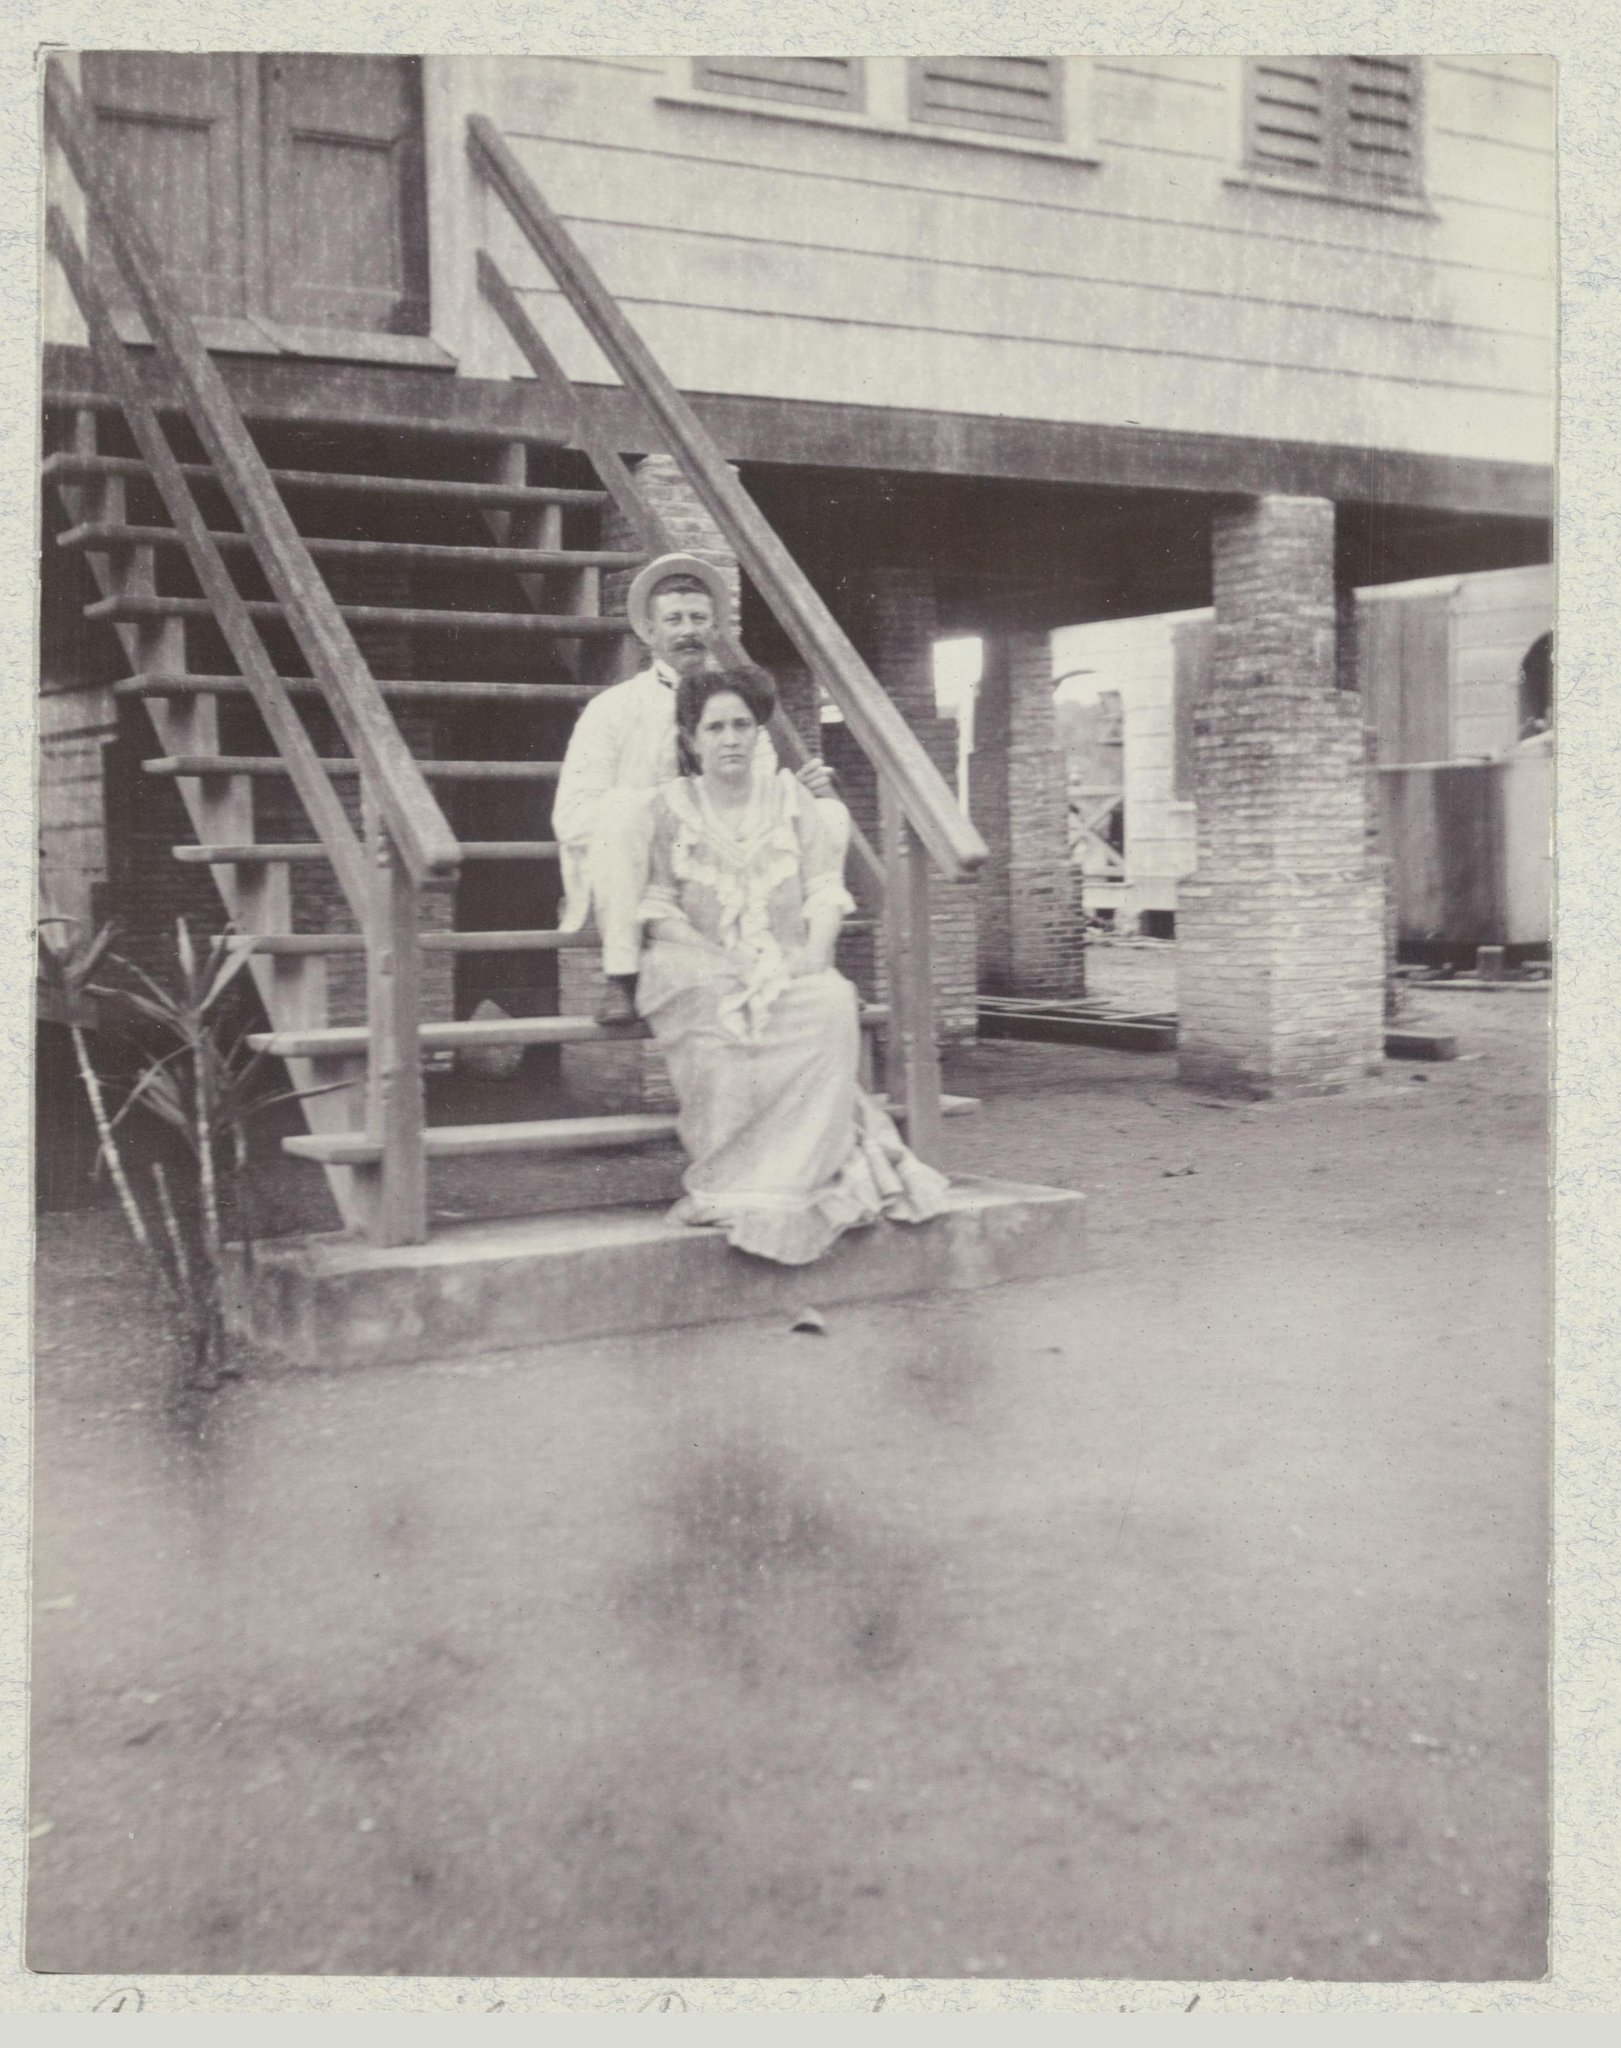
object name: photograph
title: Post Leyden, Paramaribo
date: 1907-1908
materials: photographic support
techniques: photography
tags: andries augustus boom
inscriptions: inscription: ‘Paramaribo "Post Leyden". Juli 1908’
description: Mevr. de Vries en A.A. Boom zittend op de trap van een gebouw "Post Leyden", Paramaribo, juli 1908. Onderdeel van het fotoalbum van de familie Boom-Gonggrijp in Suriname en Curaçao.